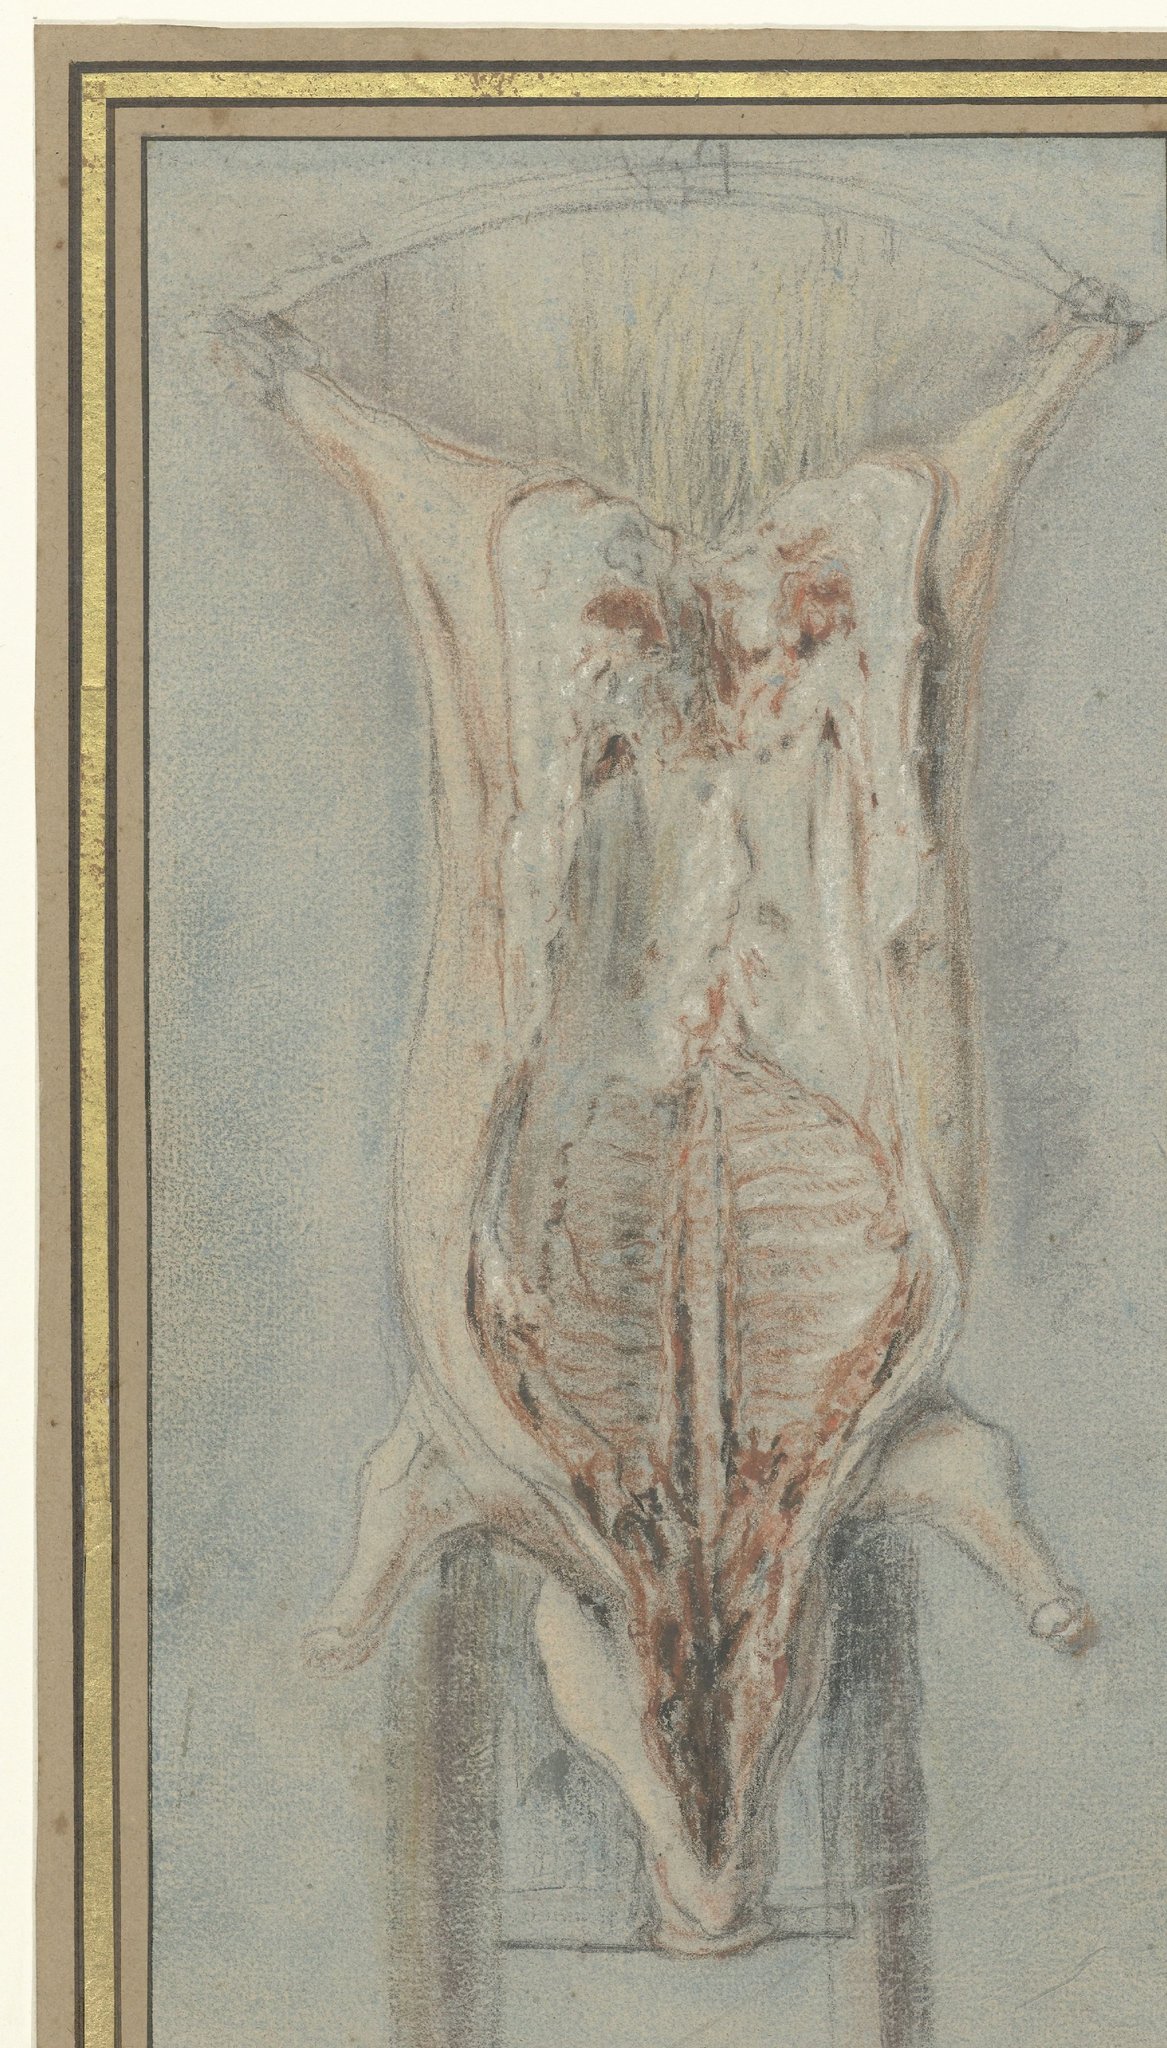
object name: drawing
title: Geslacht varken op een leer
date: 1709-1779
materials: chalk, paper, pastel, watercolor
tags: slaughtered ox or pig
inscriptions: collector's mark, recto, lower right: Lugt 1910, collector's mark, recto, lower left: Lugt 1164, annotation, verso, lower centre, pencil: ‘Verz. Gigoux / Vente 1882 frs 120 / Chardin’